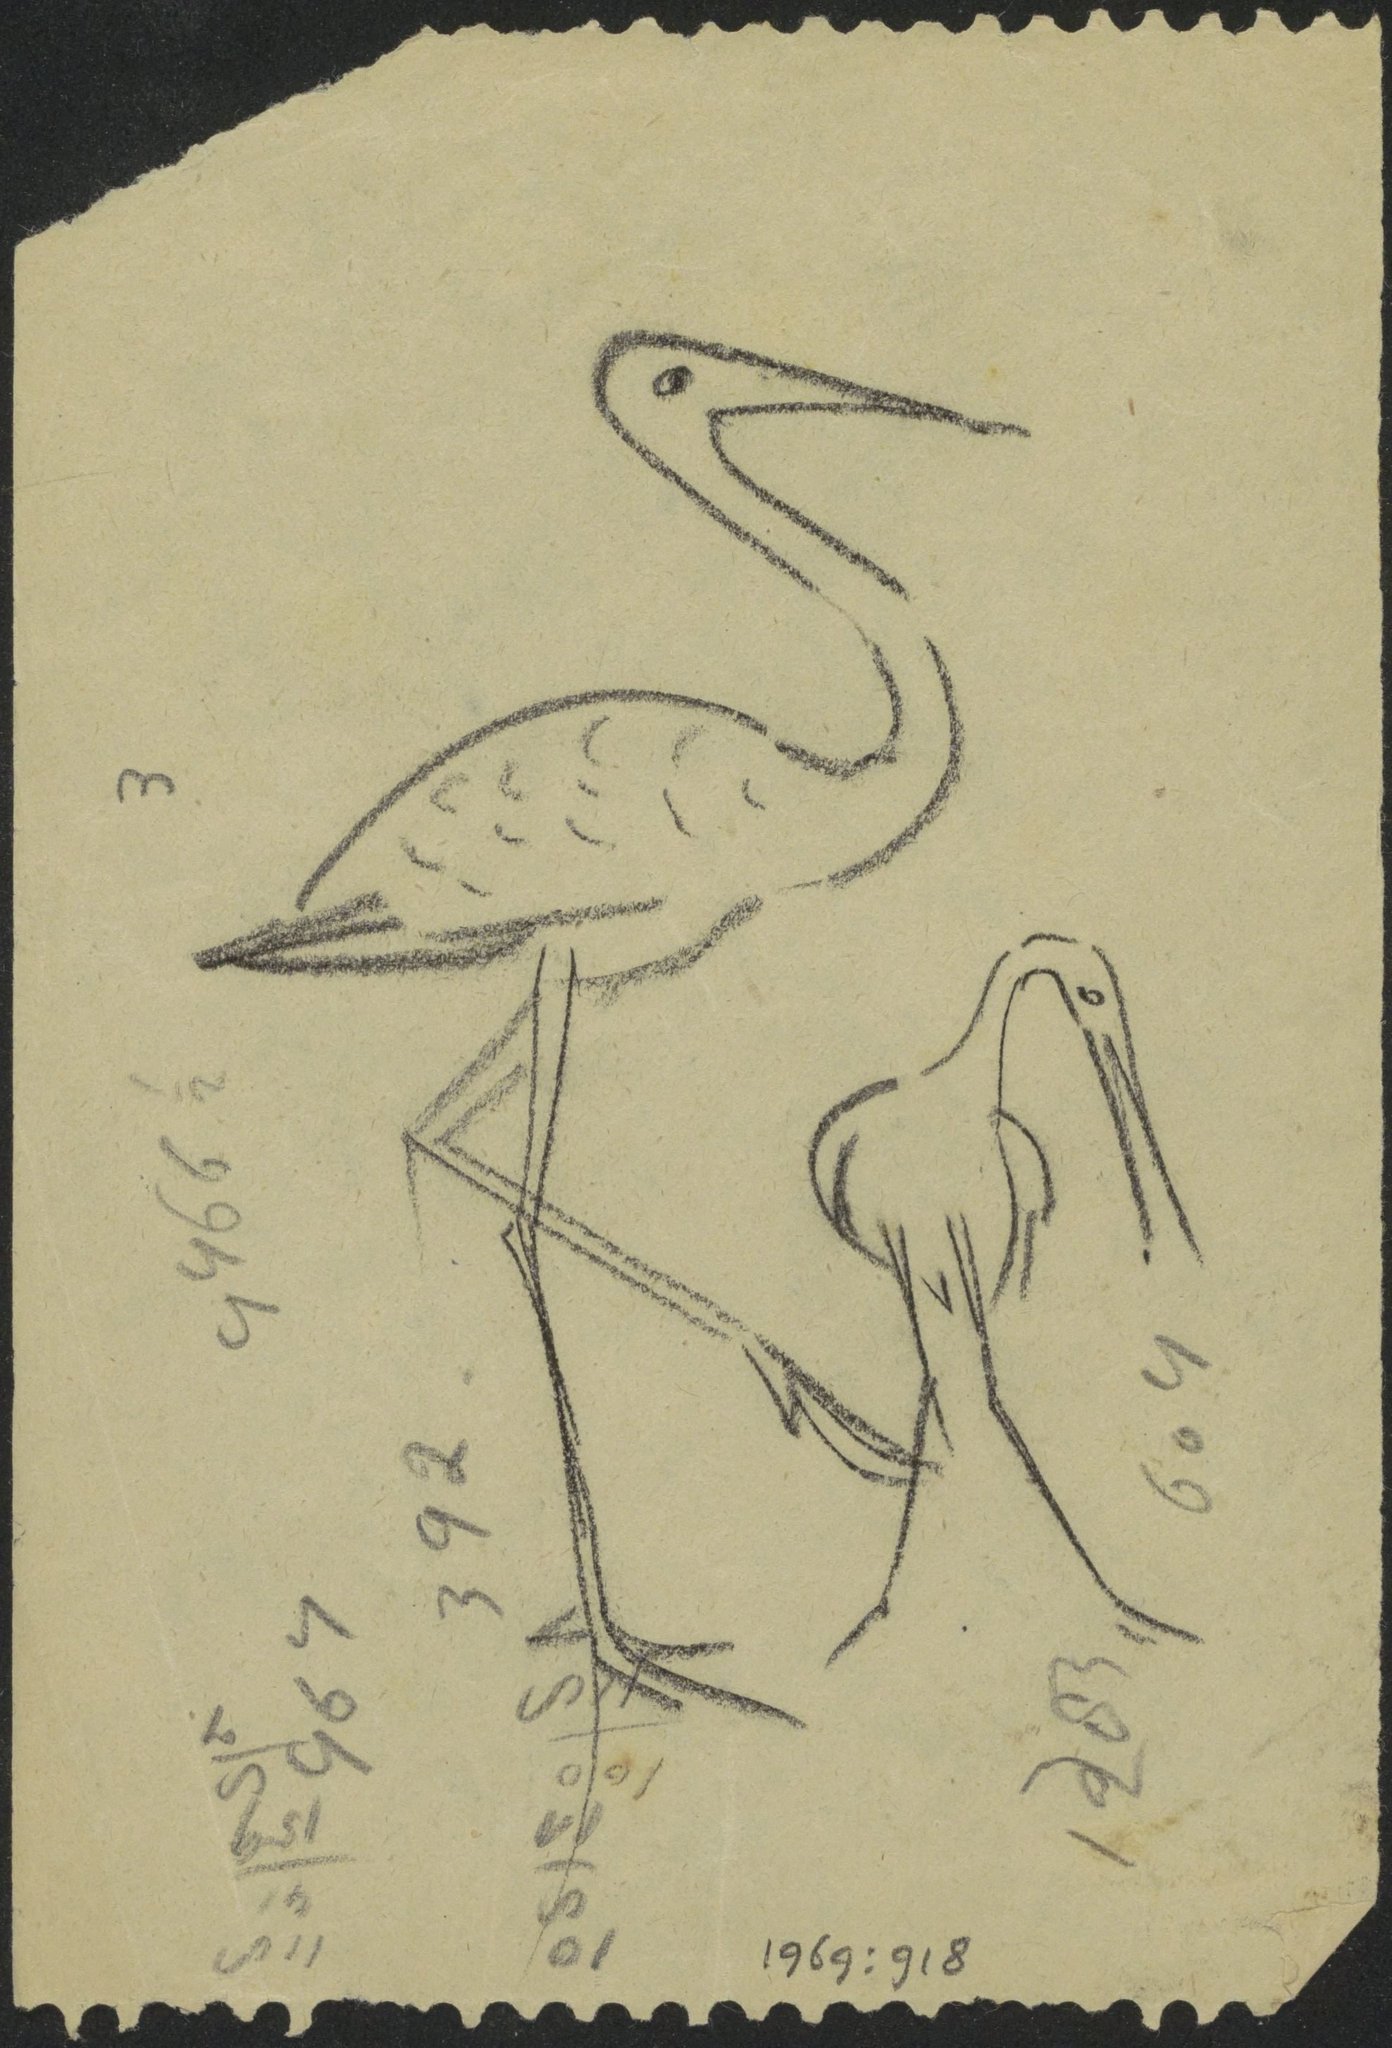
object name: drawing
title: Ooievaars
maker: gerrit willem dijsselhof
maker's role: designer, draughtsman, print maker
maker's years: 1866-1924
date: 1904-1906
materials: chalk, paper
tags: shore-birds and wading-birds: stork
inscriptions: annotation: ‘[...]’